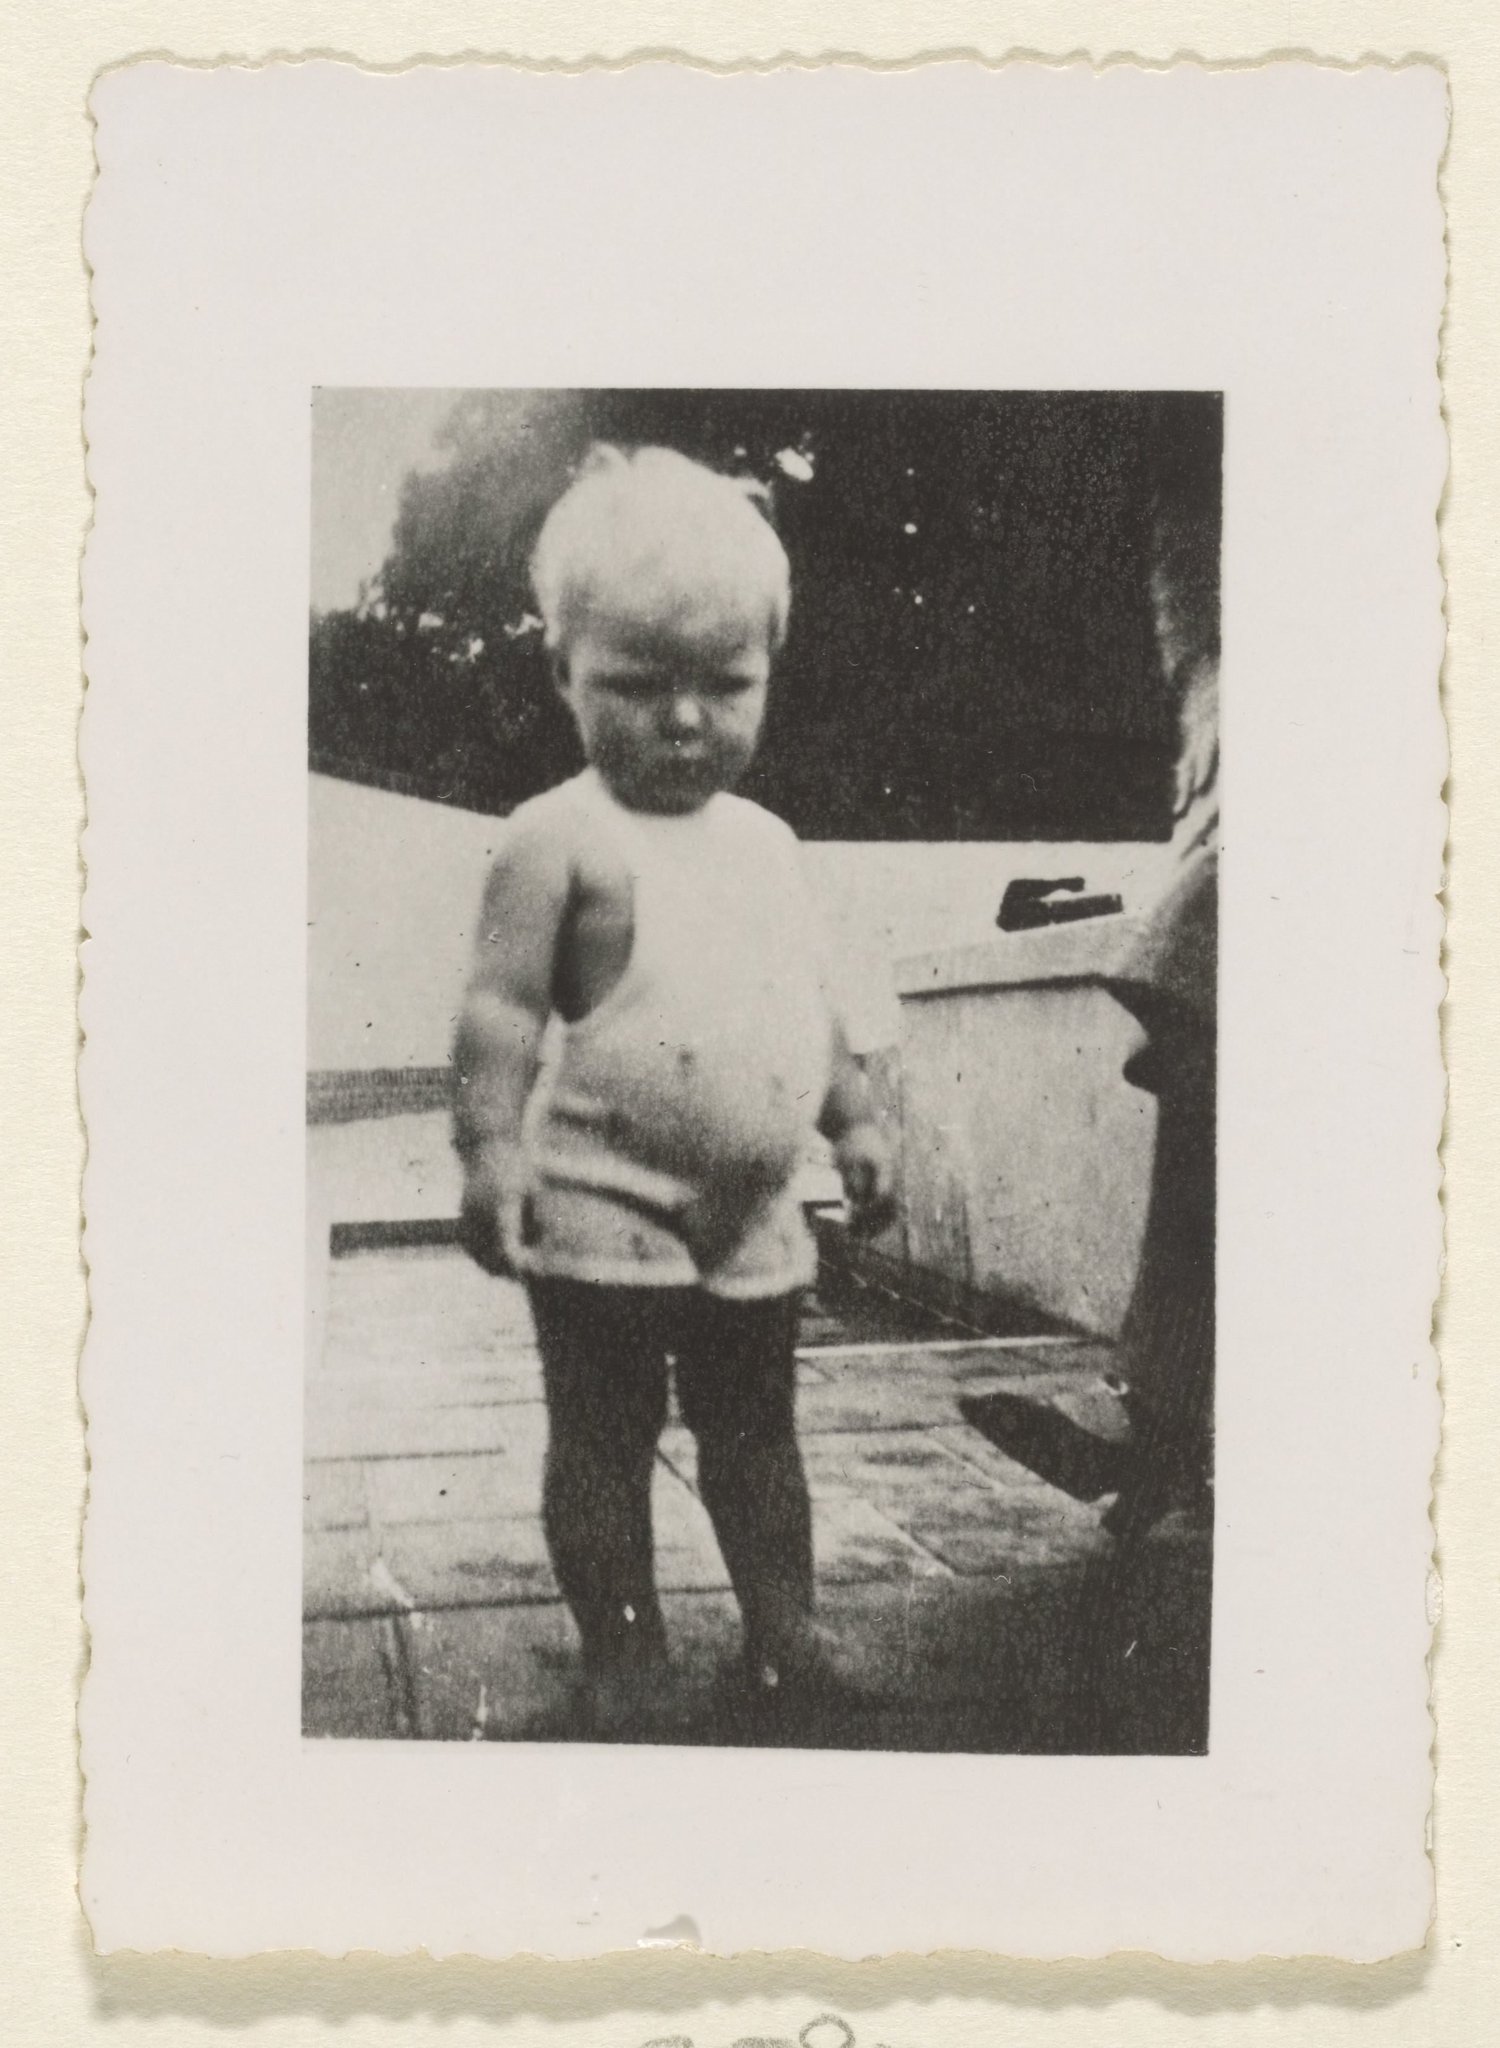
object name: photograph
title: Portret van Irene, prinses der Nederlanden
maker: Anonymous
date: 1940-1941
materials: photographic support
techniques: photography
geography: netherlands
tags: soestdijk, irene (prinses der nederlanden), ottawa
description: De hier vermelde titel verwijst naar de hoogst verkregen titel van de geportretteerde, niet per se naar de titel die de geportretteerde op deze voorstelling draagt.